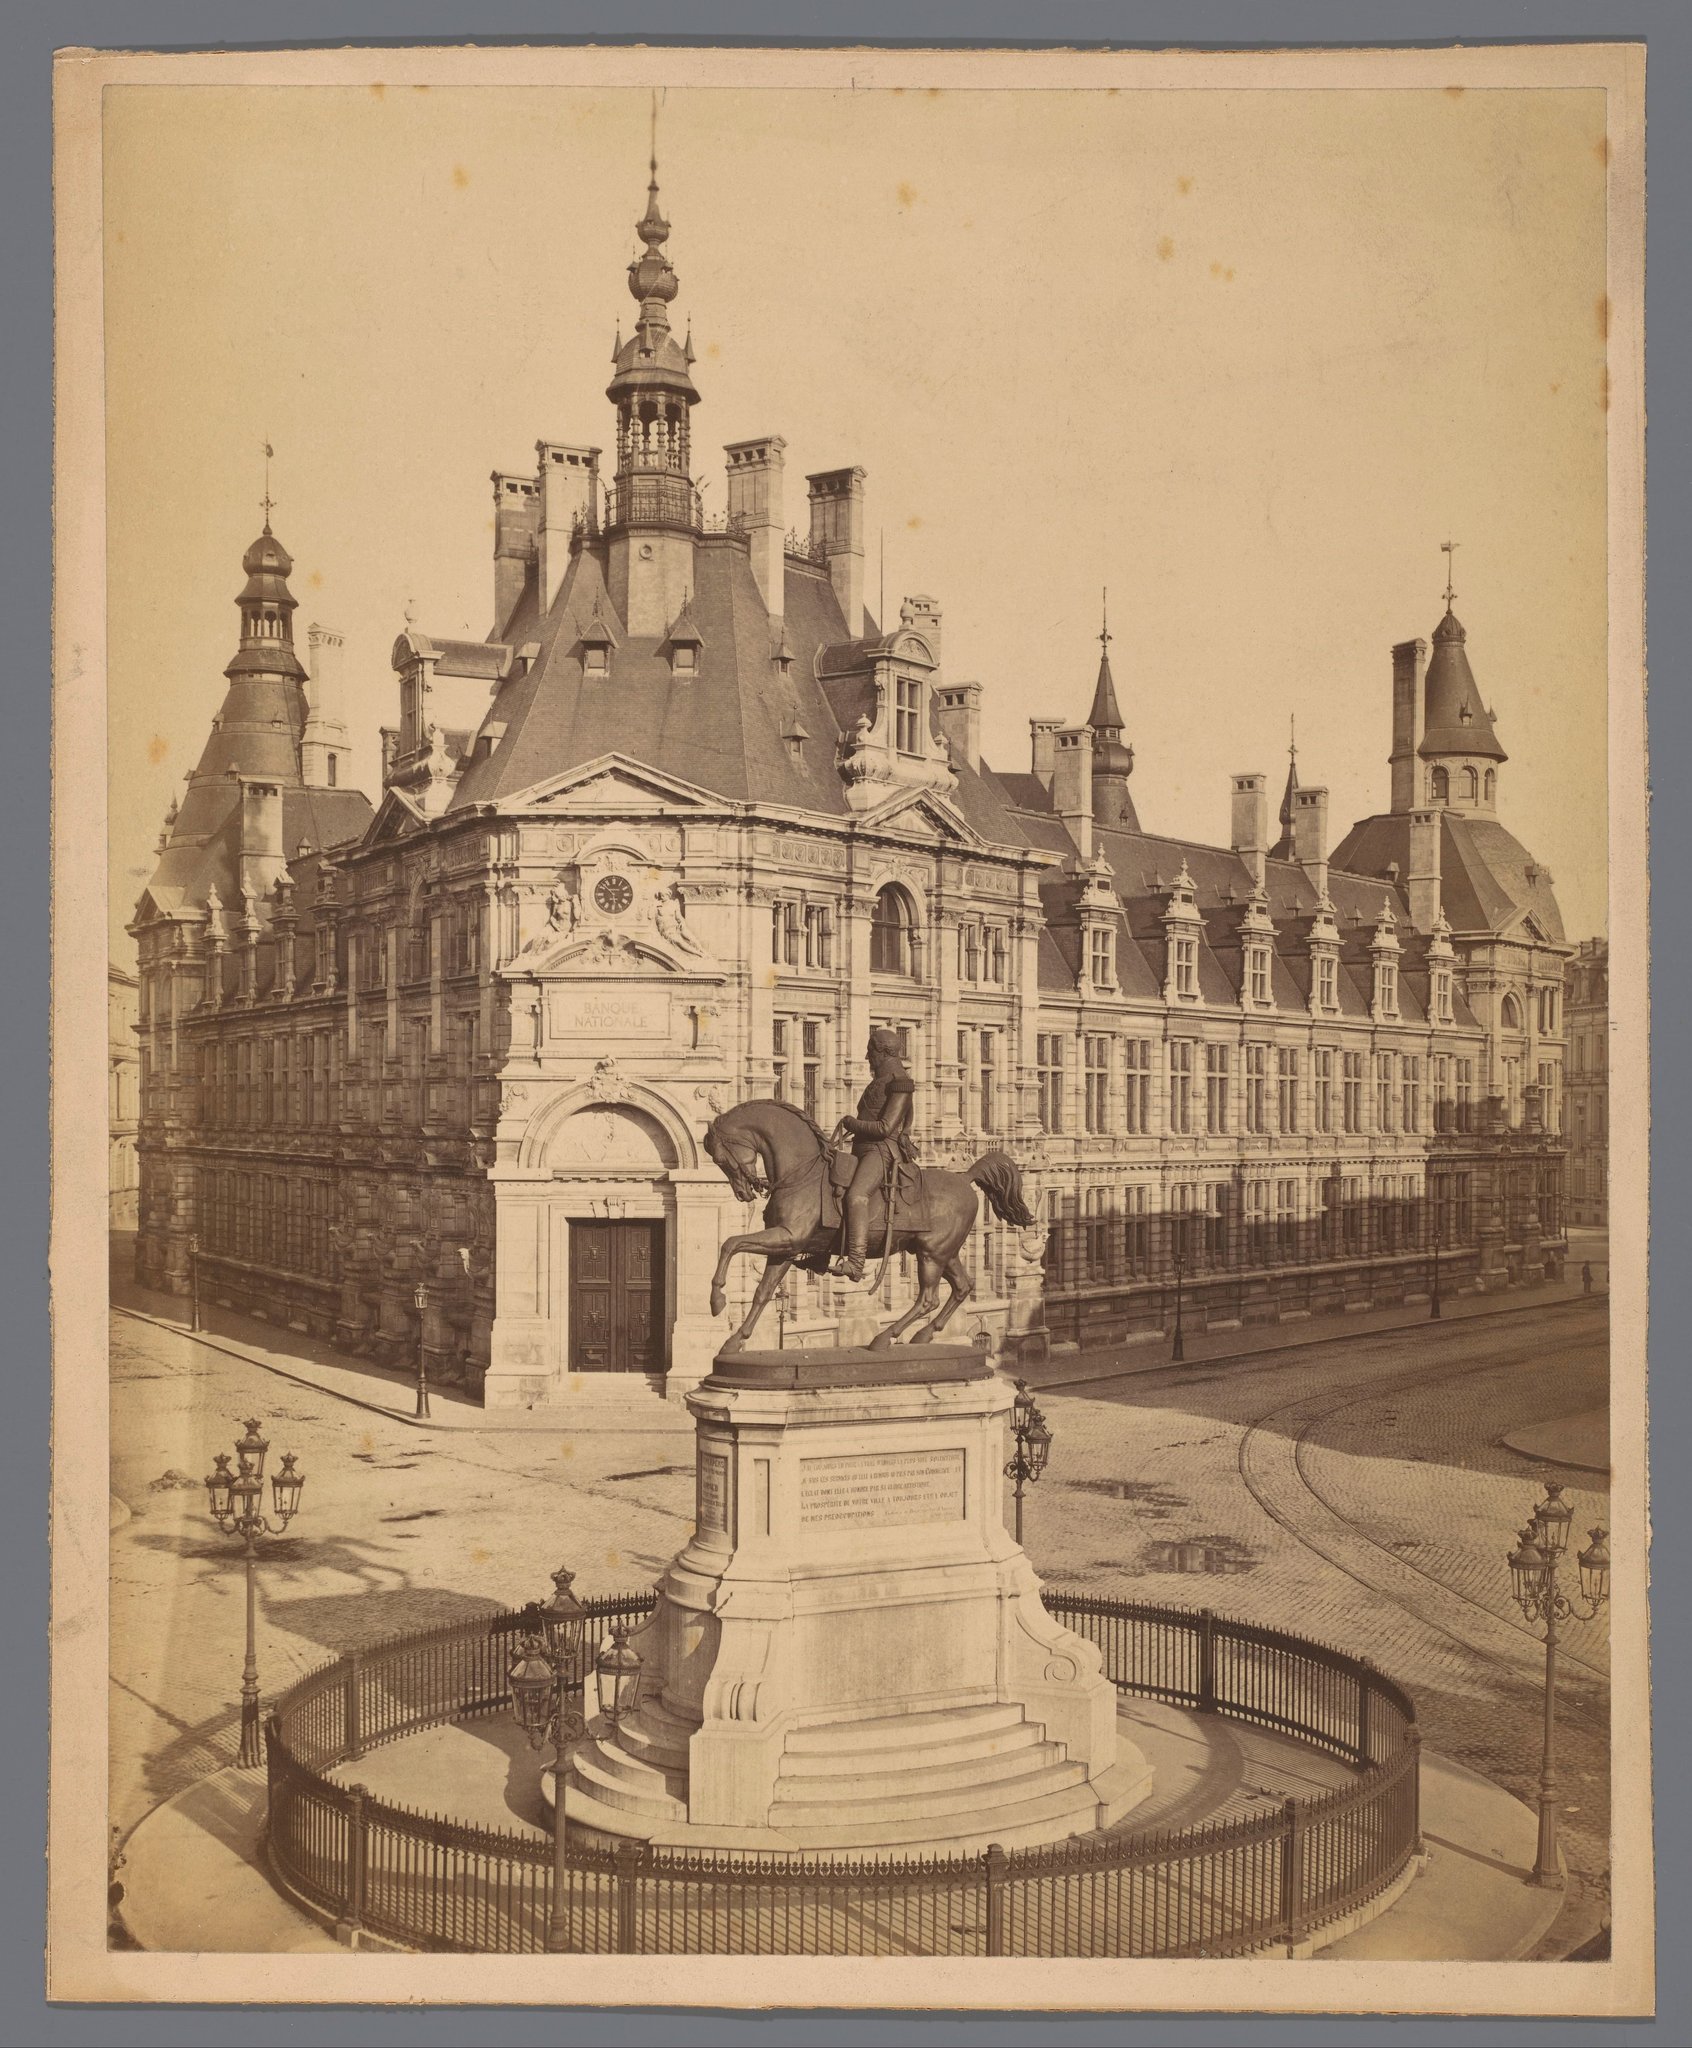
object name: photograph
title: Gezicht op het standbeeld van koning Leopold I en de Banque Nationale te Antwerpen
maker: Anonymous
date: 1872-1900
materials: cardboard, photographic support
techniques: albumen print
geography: antwerp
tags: laeken, leopold i (koning der belgen), monument, statue, bank, antwerp